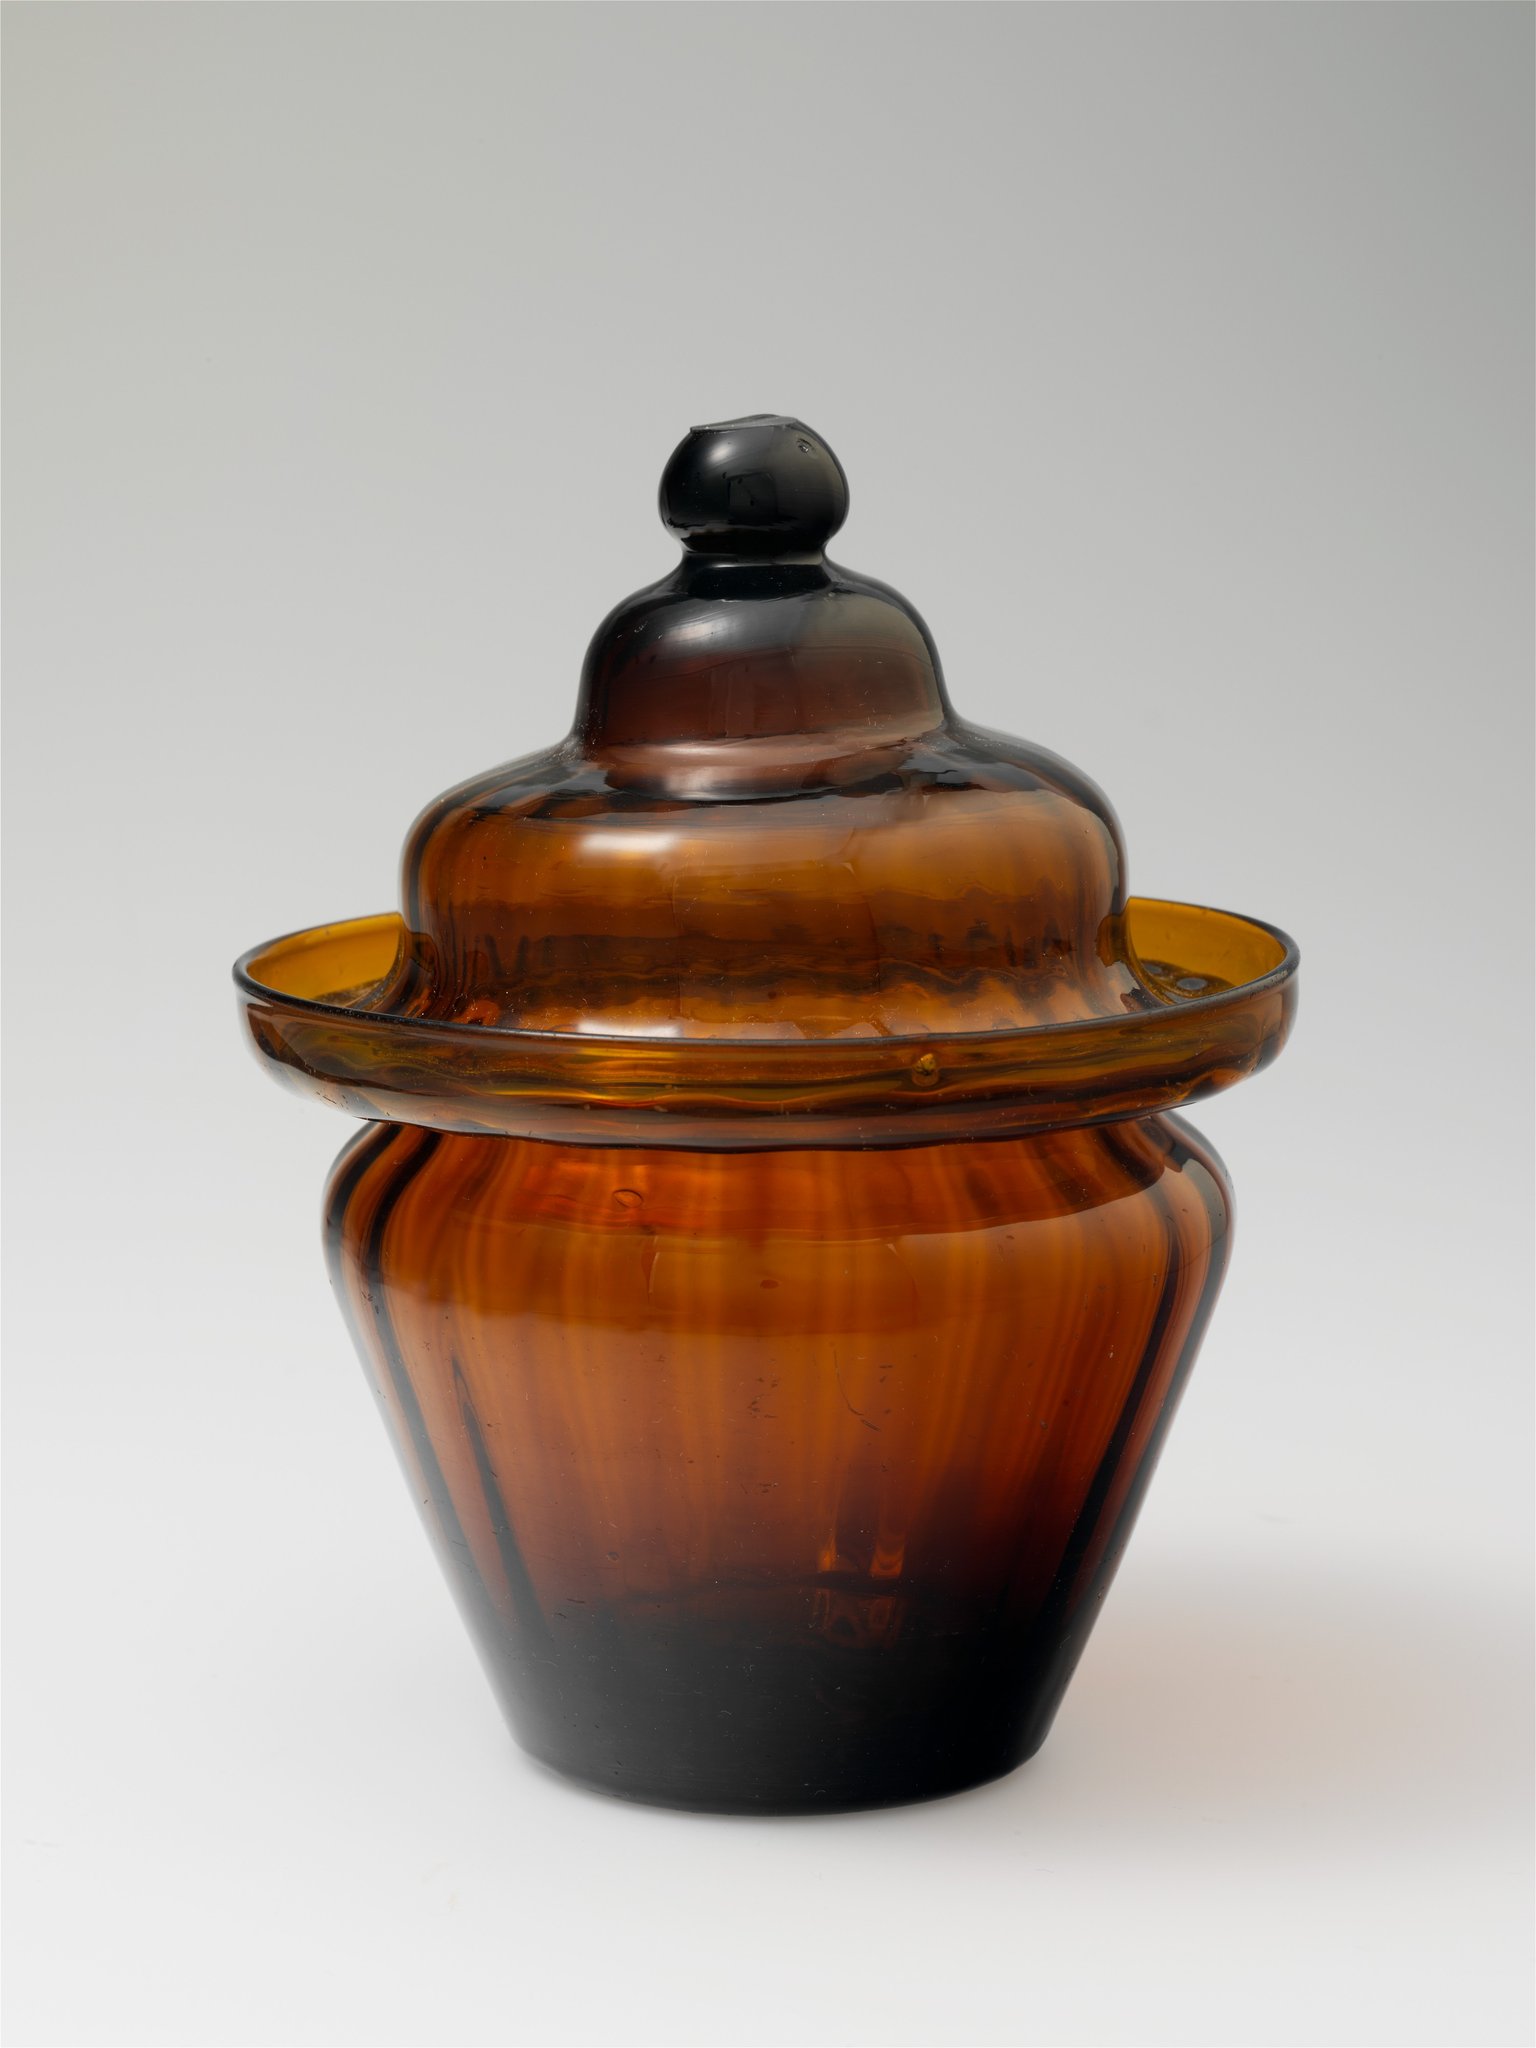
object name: sugar bowl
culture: american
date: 1815-1835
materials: glass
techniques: glassblowing, molding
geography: united states